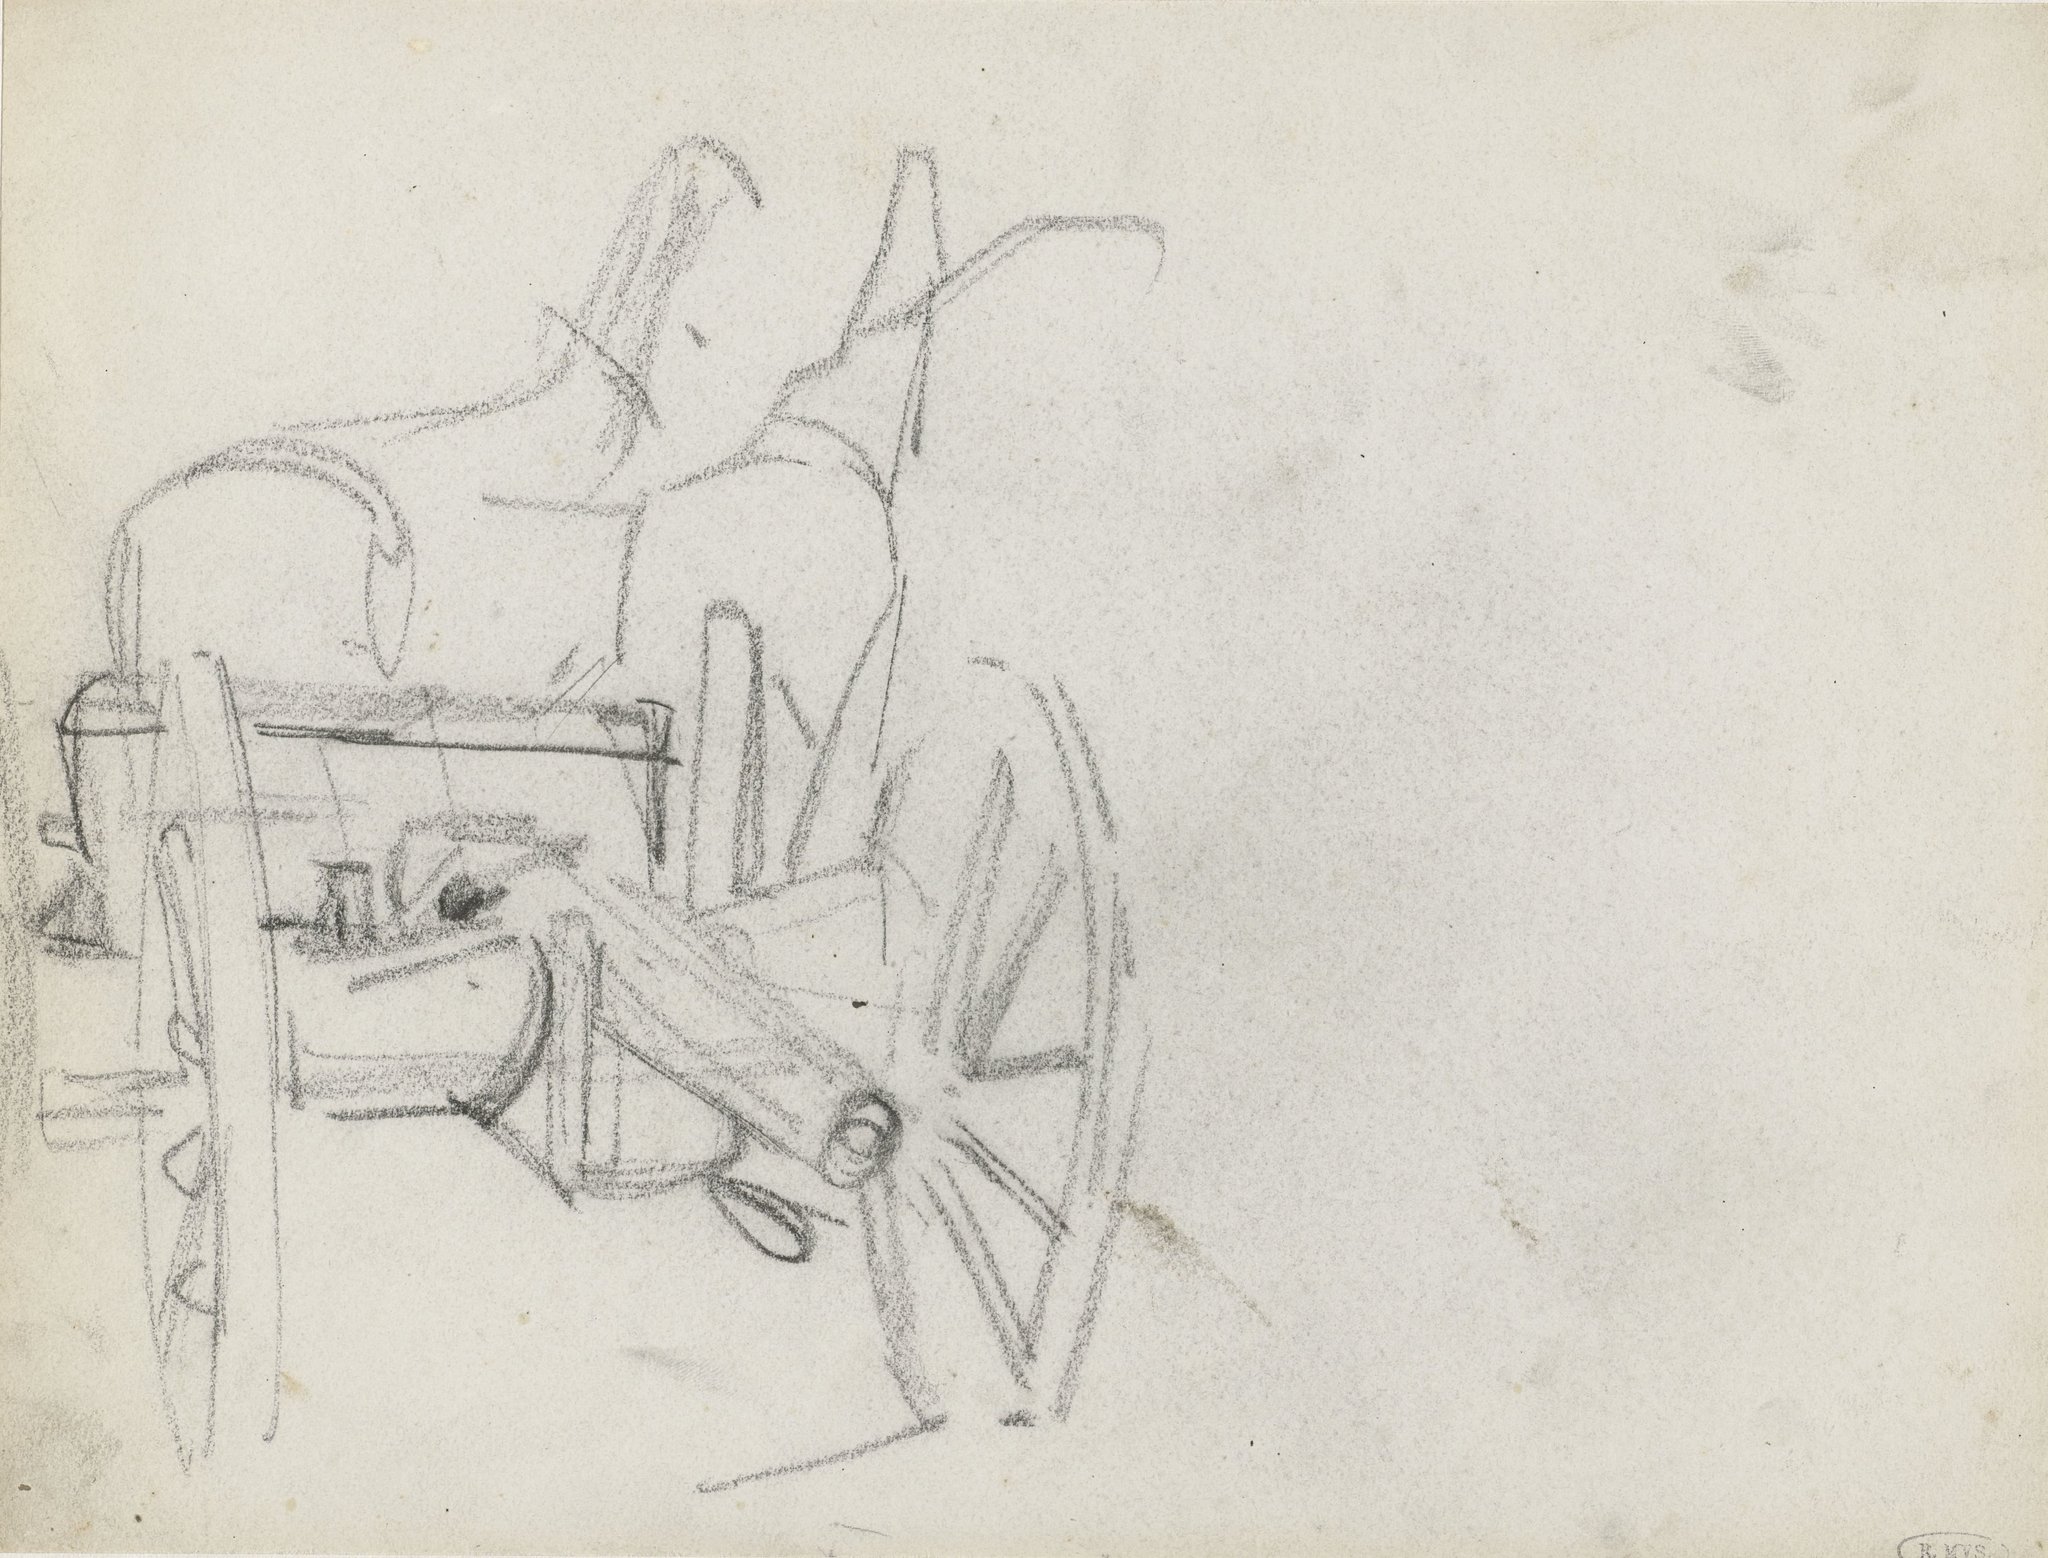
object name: drawing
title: Paarden met geschut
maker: george hendrik breitner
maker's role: draughtsman, painter, print maker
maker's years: 1857-1923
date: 1867-1923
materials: chalk, paper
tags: firearms: cannon